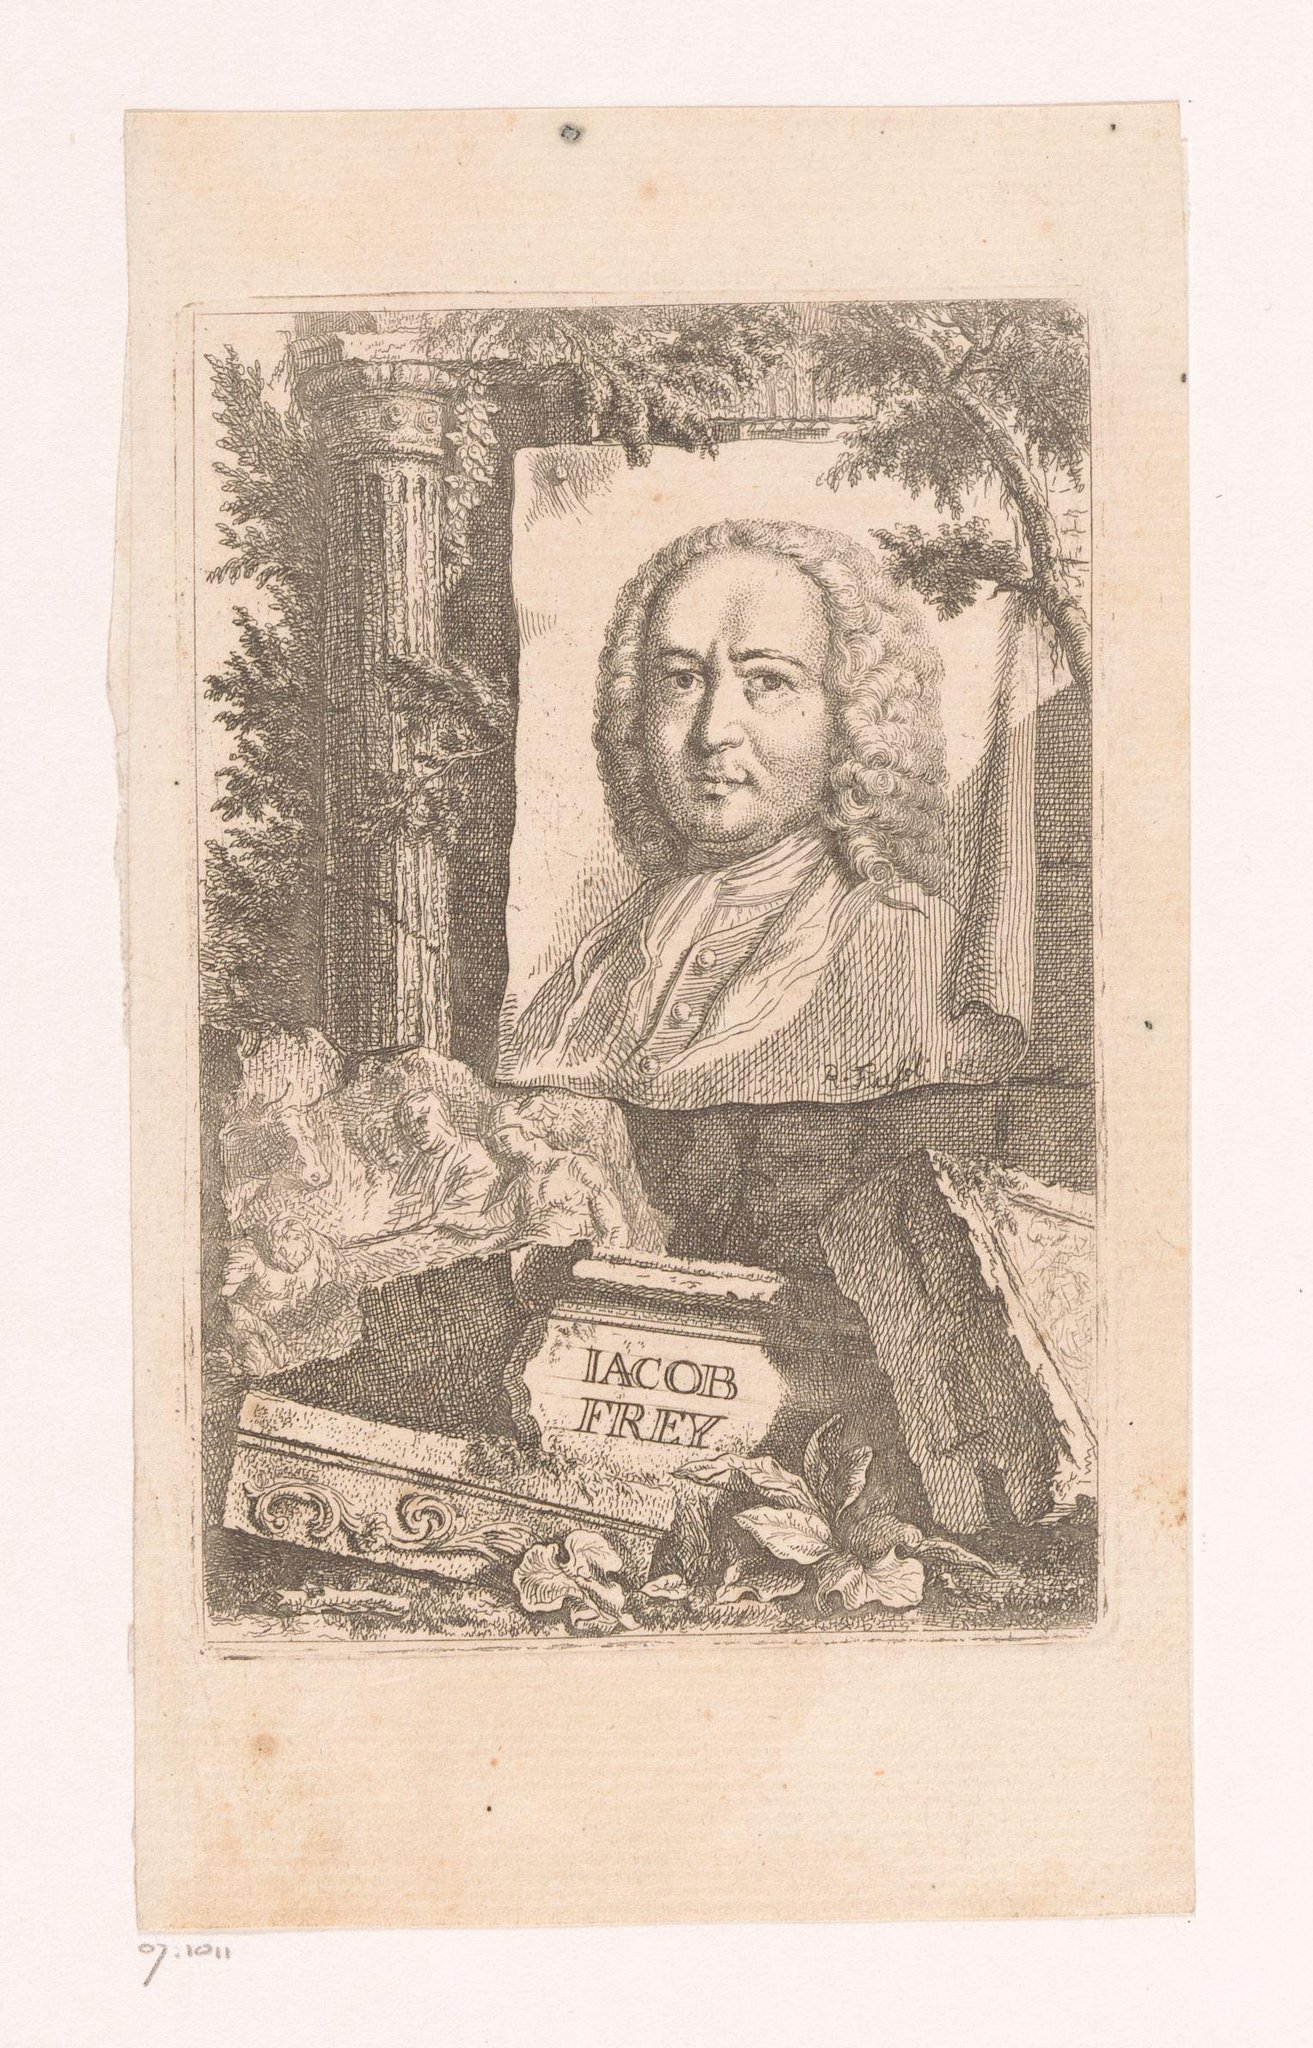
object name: print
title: Portret van Jacob Frey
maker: rudolf füssli (der jüngste)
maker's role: print maker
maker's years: 1737-1806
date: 1755-1757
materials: paper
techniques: etching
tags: ruin of a building ~ architecture, historical persons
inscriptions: collector's mark: Lugt 2228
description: Prent gebruikt voor: Füssli, Johann Kaspar. Geschichte Und Abbildung der besten Mahler in der Schweitz. Zürich: David Gessner, 1755-1757.